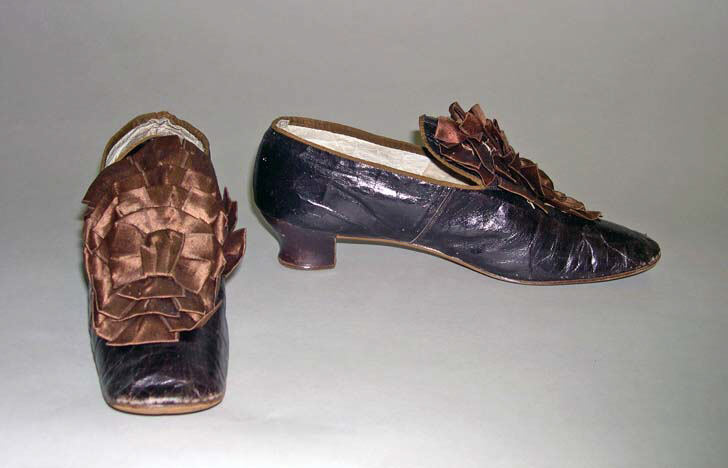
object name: shoe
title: Shoes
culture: american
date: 1860-1879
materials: leather, silk, wood